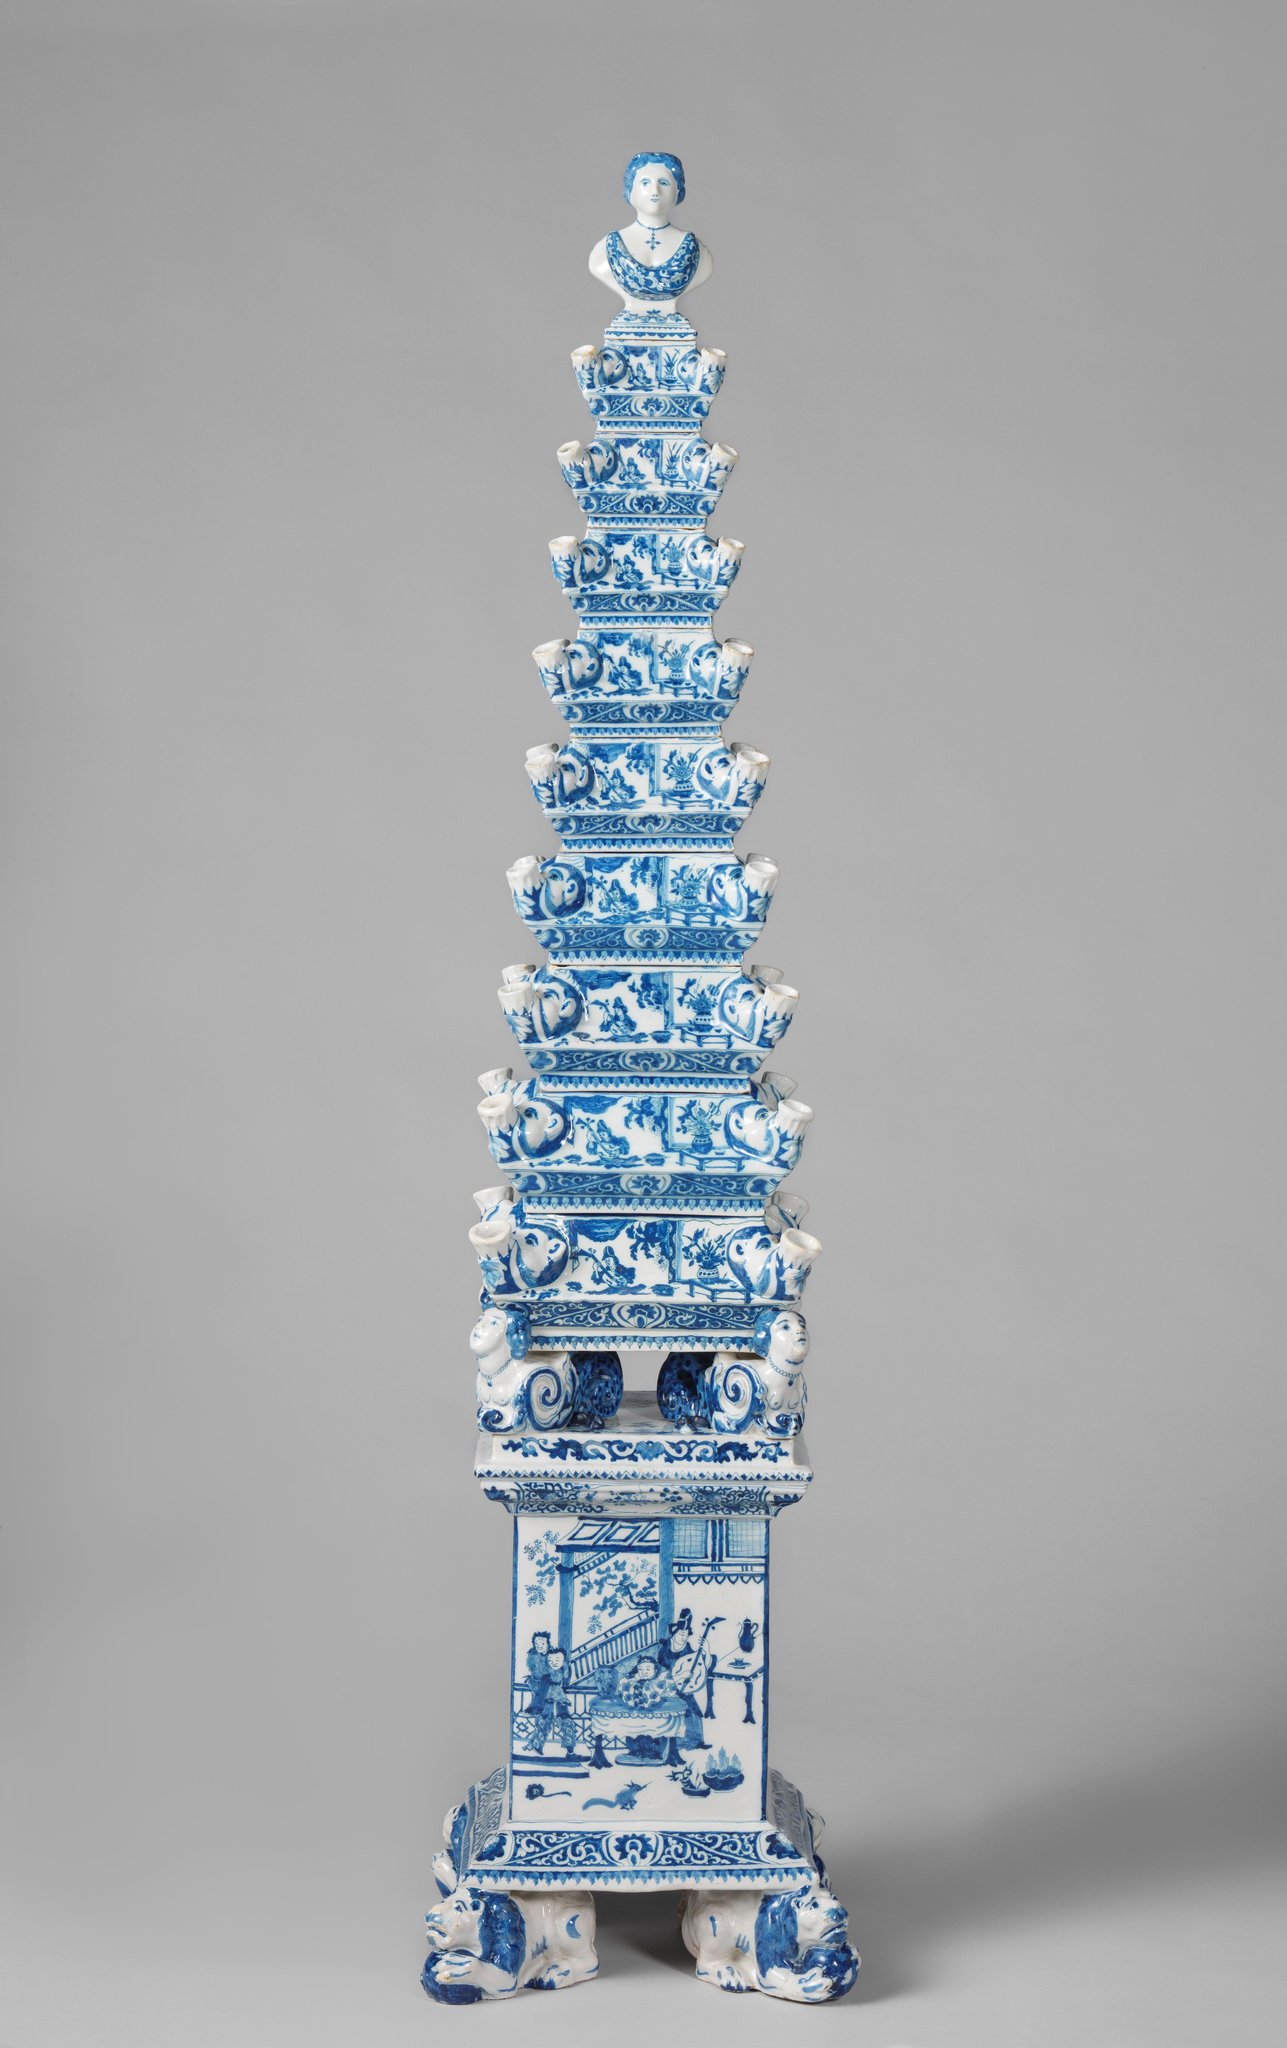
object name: bloempiramide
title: Flower pyramid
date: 2003-2004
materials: earthenware, glaze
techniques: painted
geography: makkum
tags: flowers, one person playing string instrument (plucked), beasts of prey, predatory animals: lion, chest, bust - aa - female human figure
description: Segment van bloempiramide van faience, blauw beschilderd in de glazuur. Musicerende figuren en figuren met schaal.